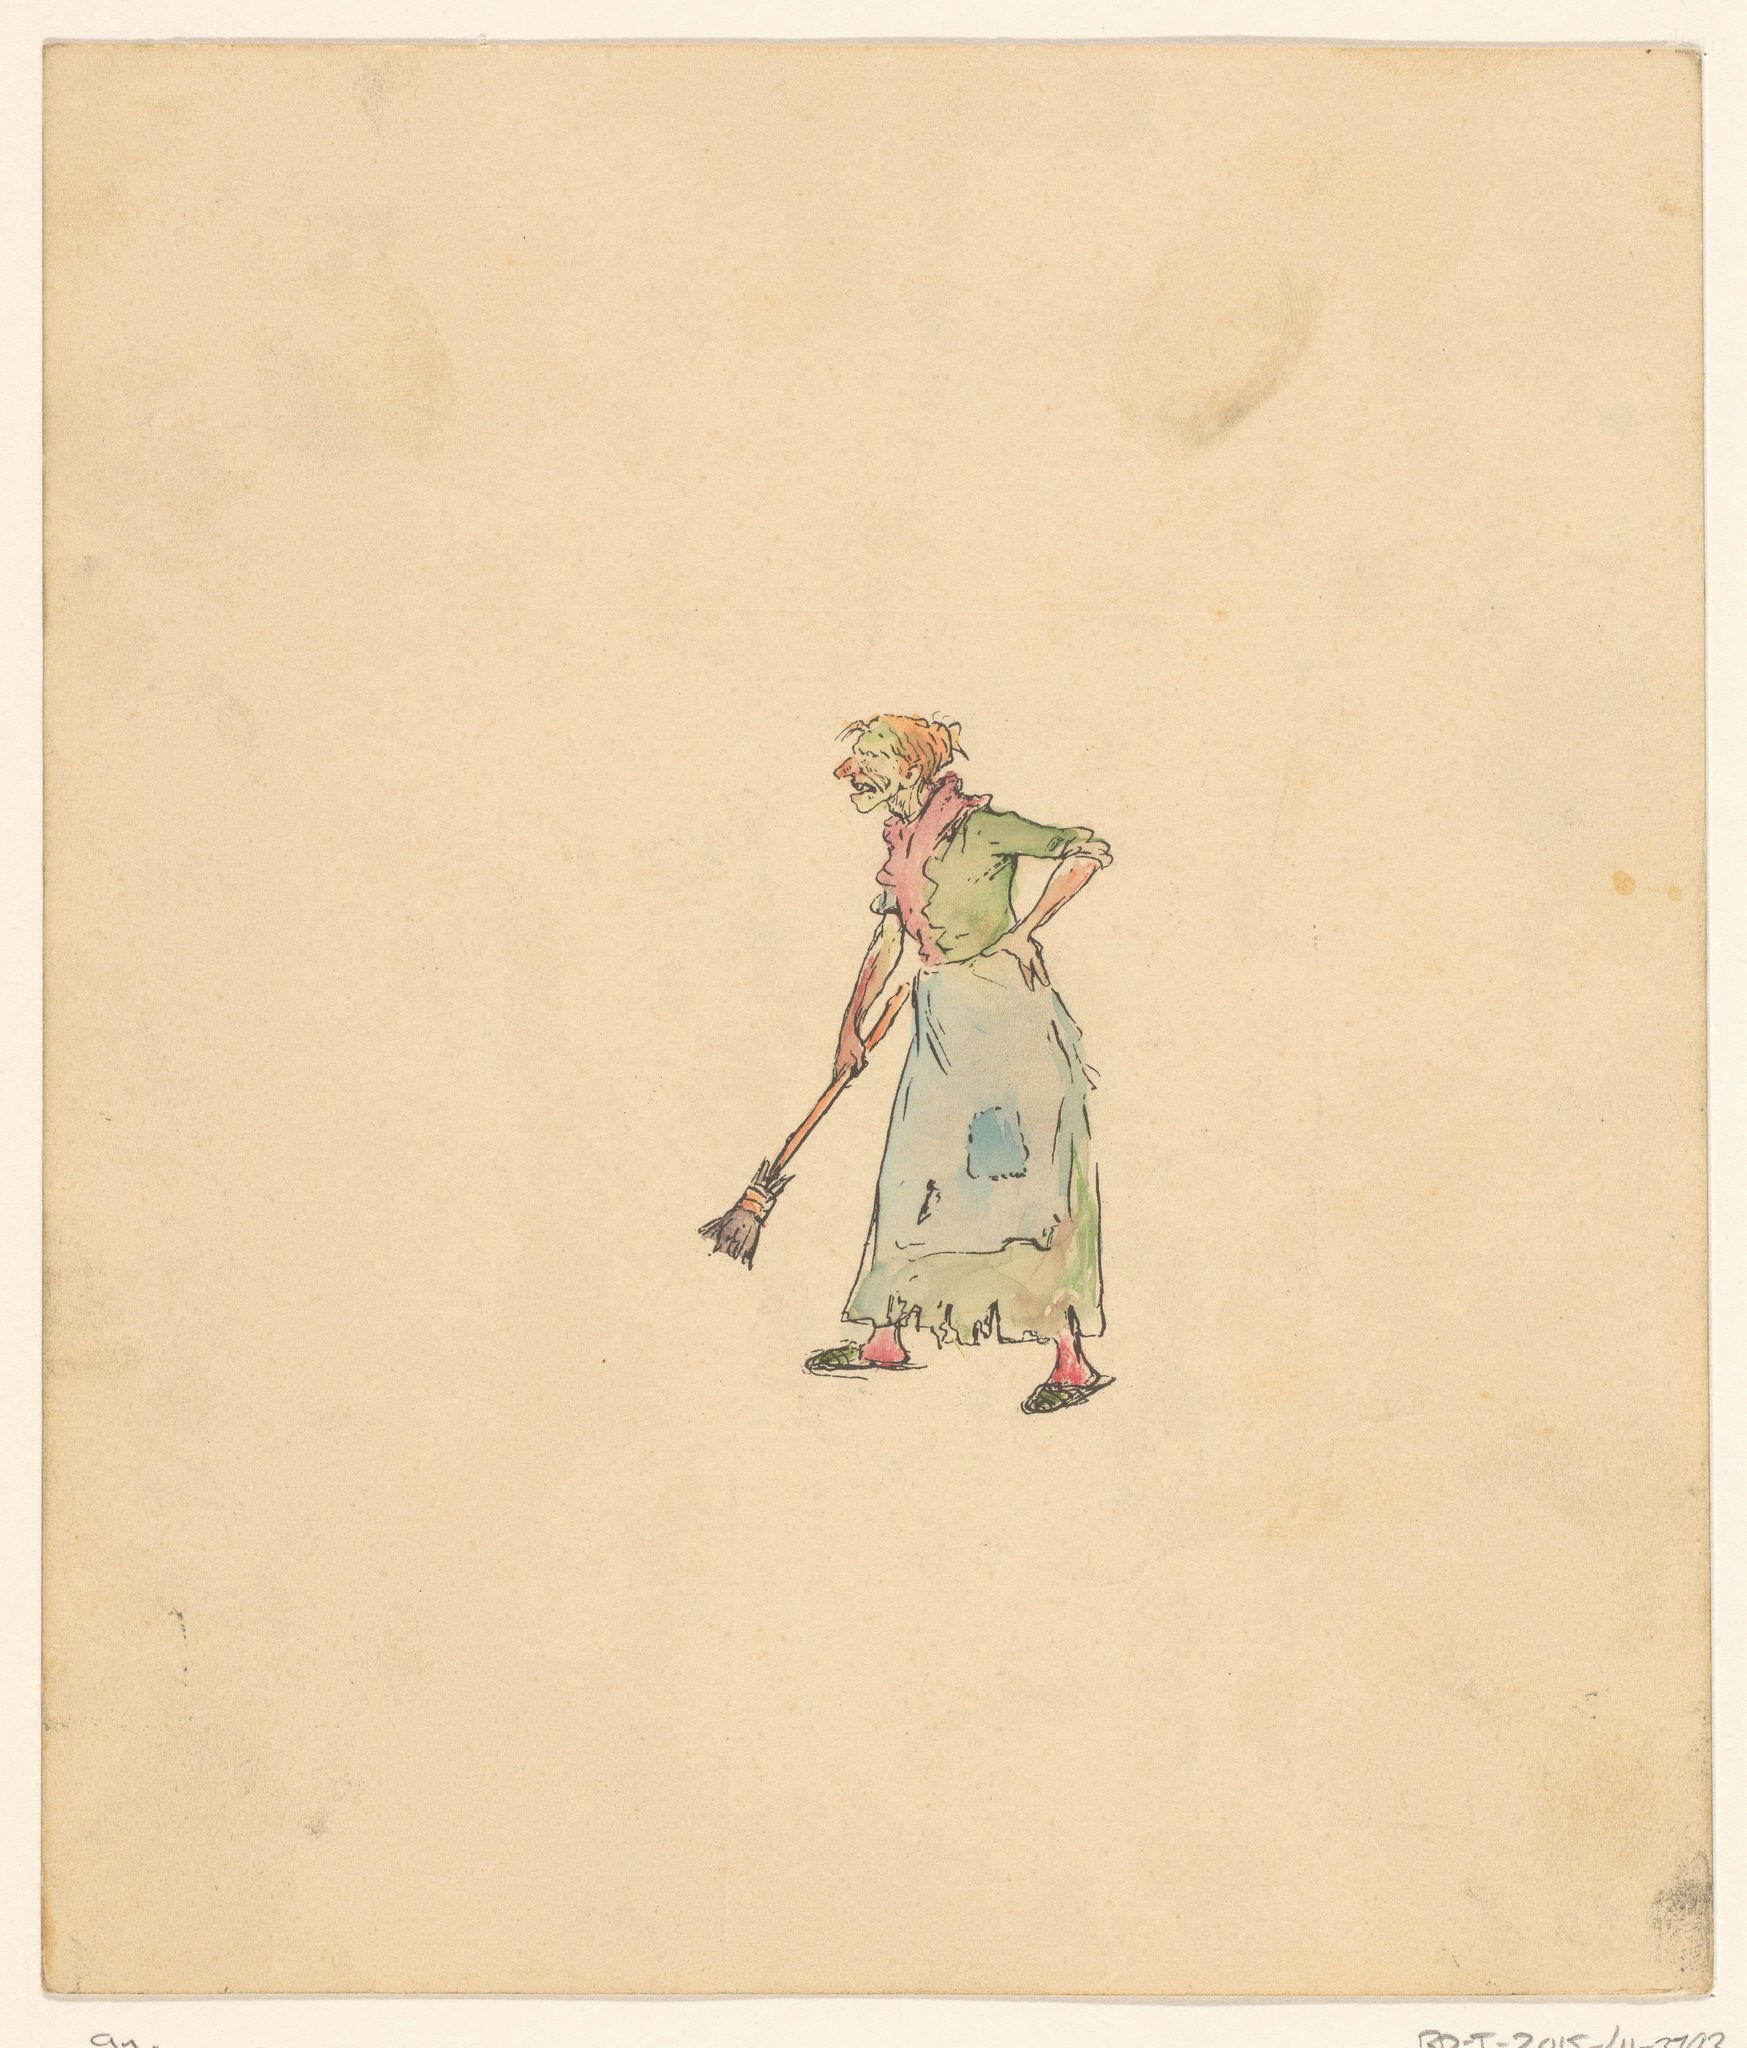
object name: drawing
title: Oude vrouw met bezem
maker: Anonymous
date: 1880-1910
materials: ink, paper, watercolor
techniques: brush, pen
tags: clothed in rags, ugly old woman, hag, (household) utensils and implements (with name)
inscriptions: collector's mark: Lugt 2228a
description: Een oude vrouw in gerafelde en verstelde kleding staat met een bezem in de hand.